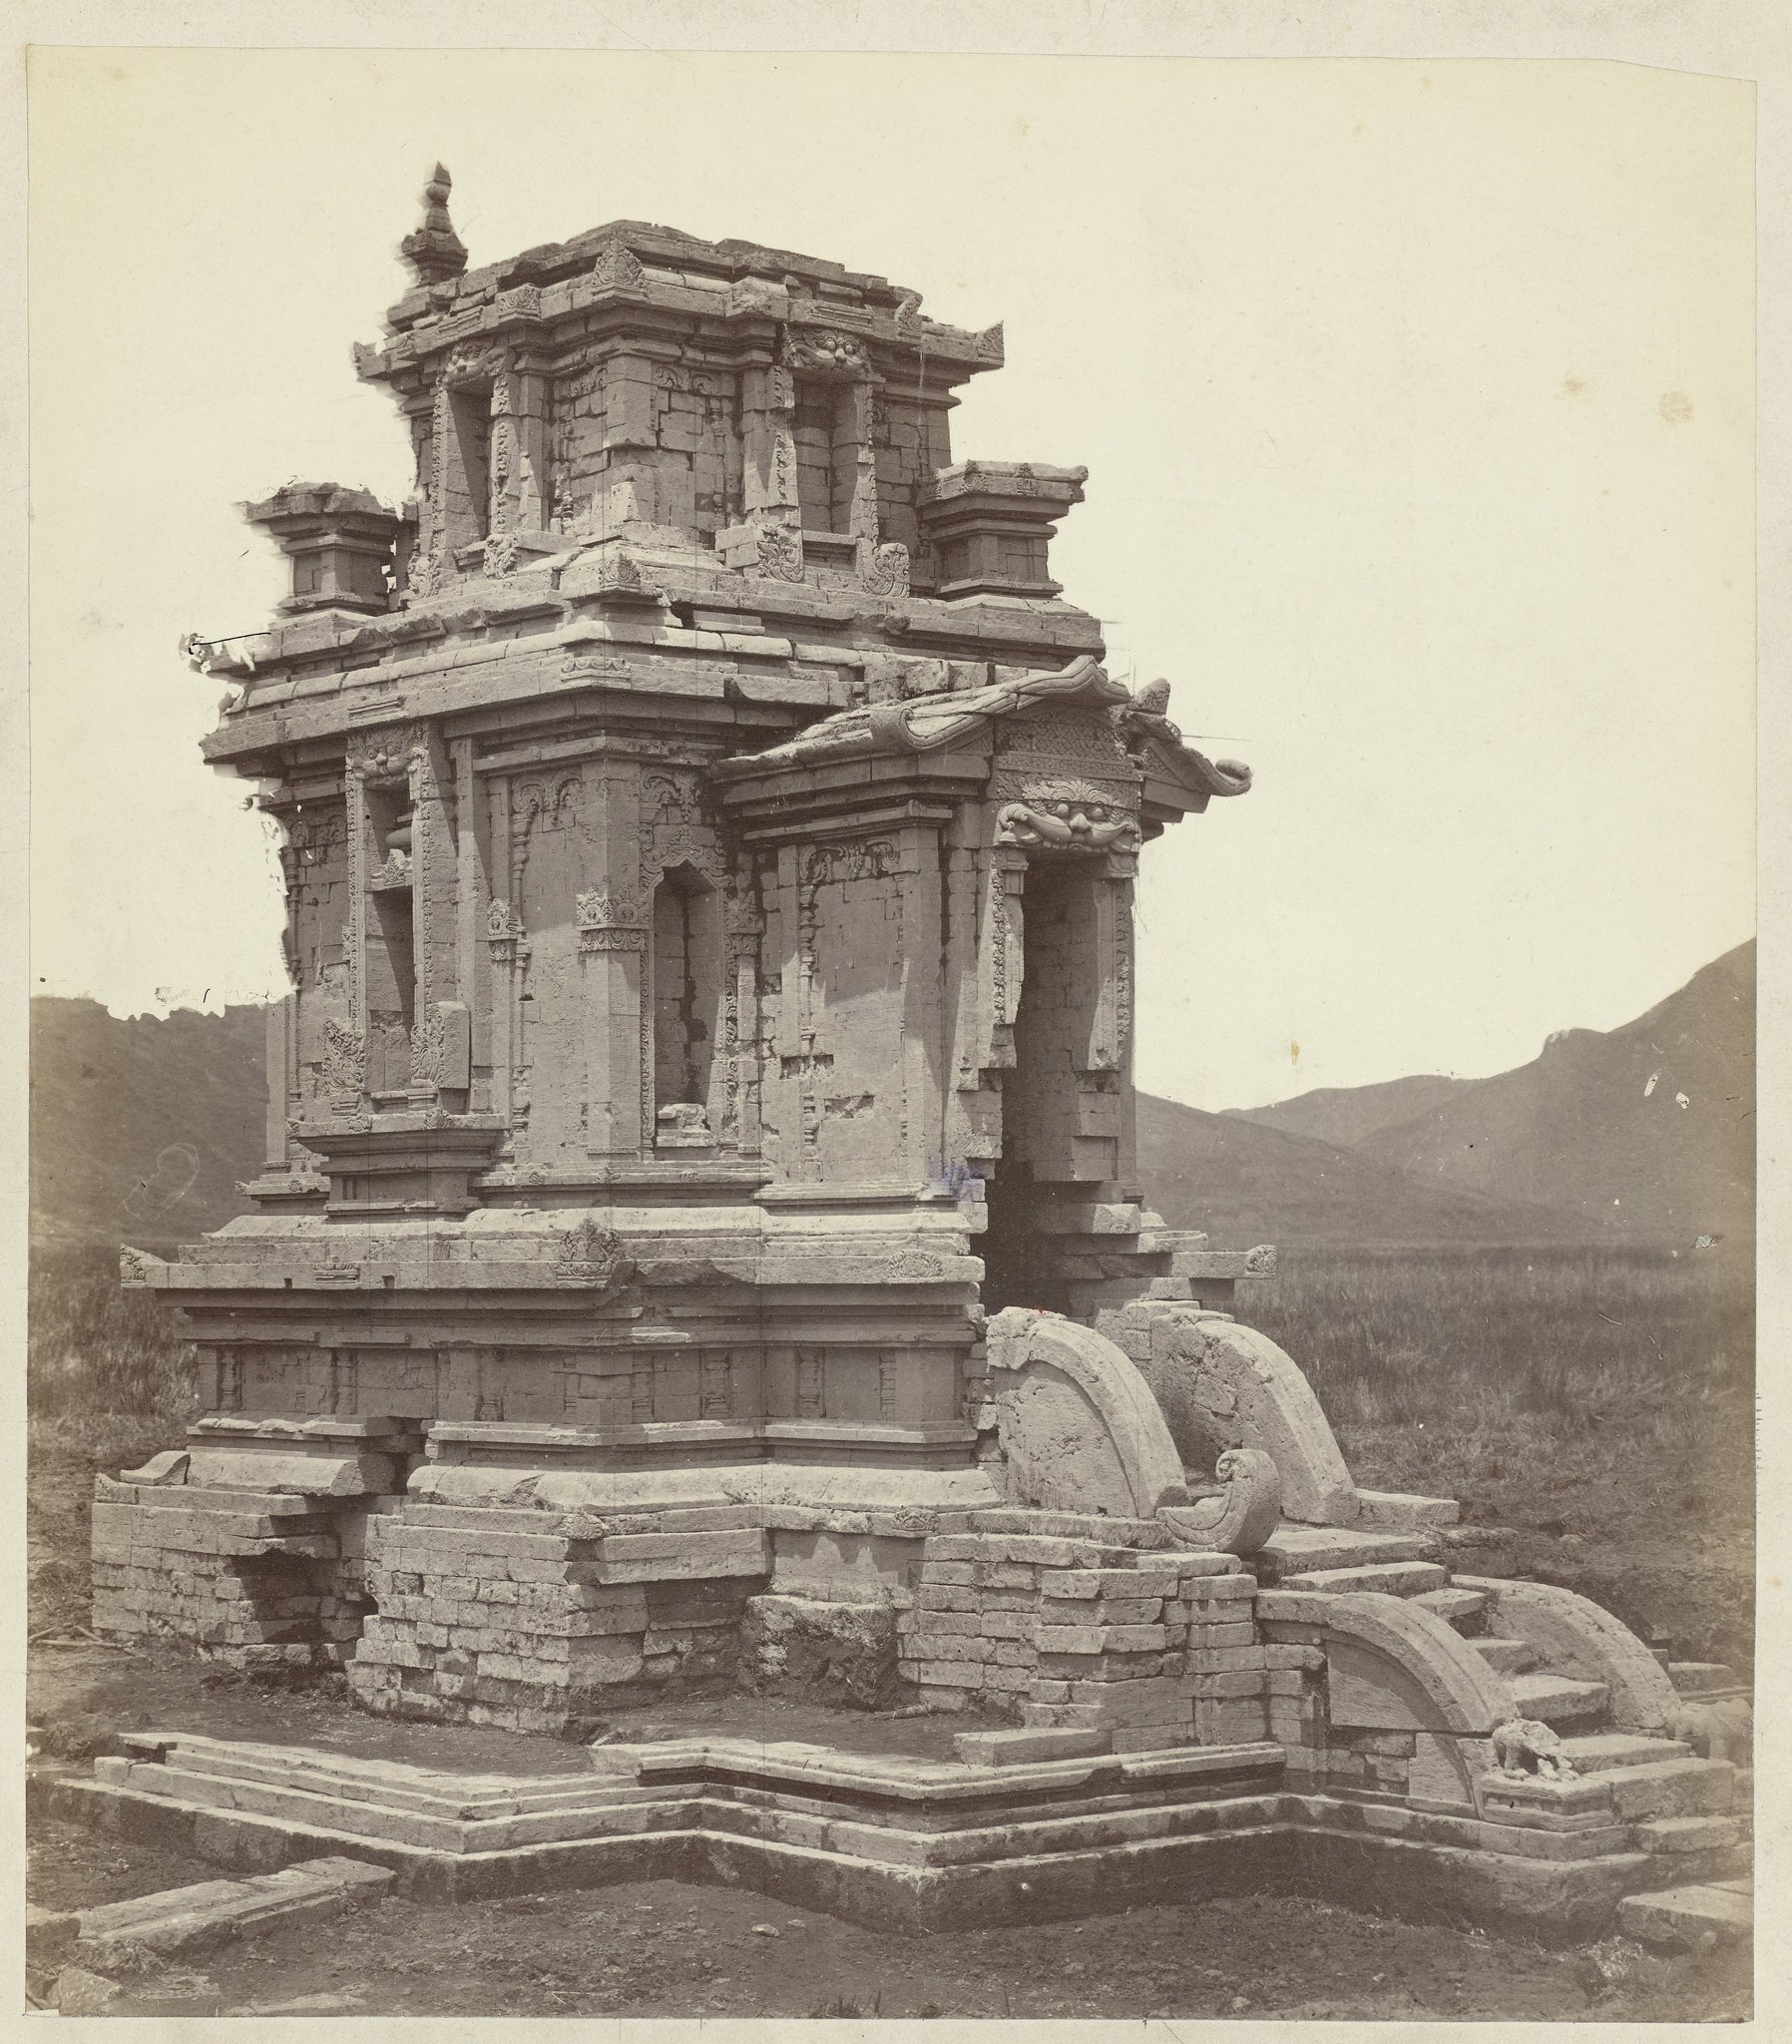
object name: photograph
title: Candi Puntadewa, general view with the staircase projection (west). Dieng plateau Wonosobo district, Central Java province 8th-9th century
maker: isidore kinsbergen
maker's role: fotograaf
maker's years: 1821-1905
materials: cardboard, paper, photographic support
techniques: albumen print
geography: java